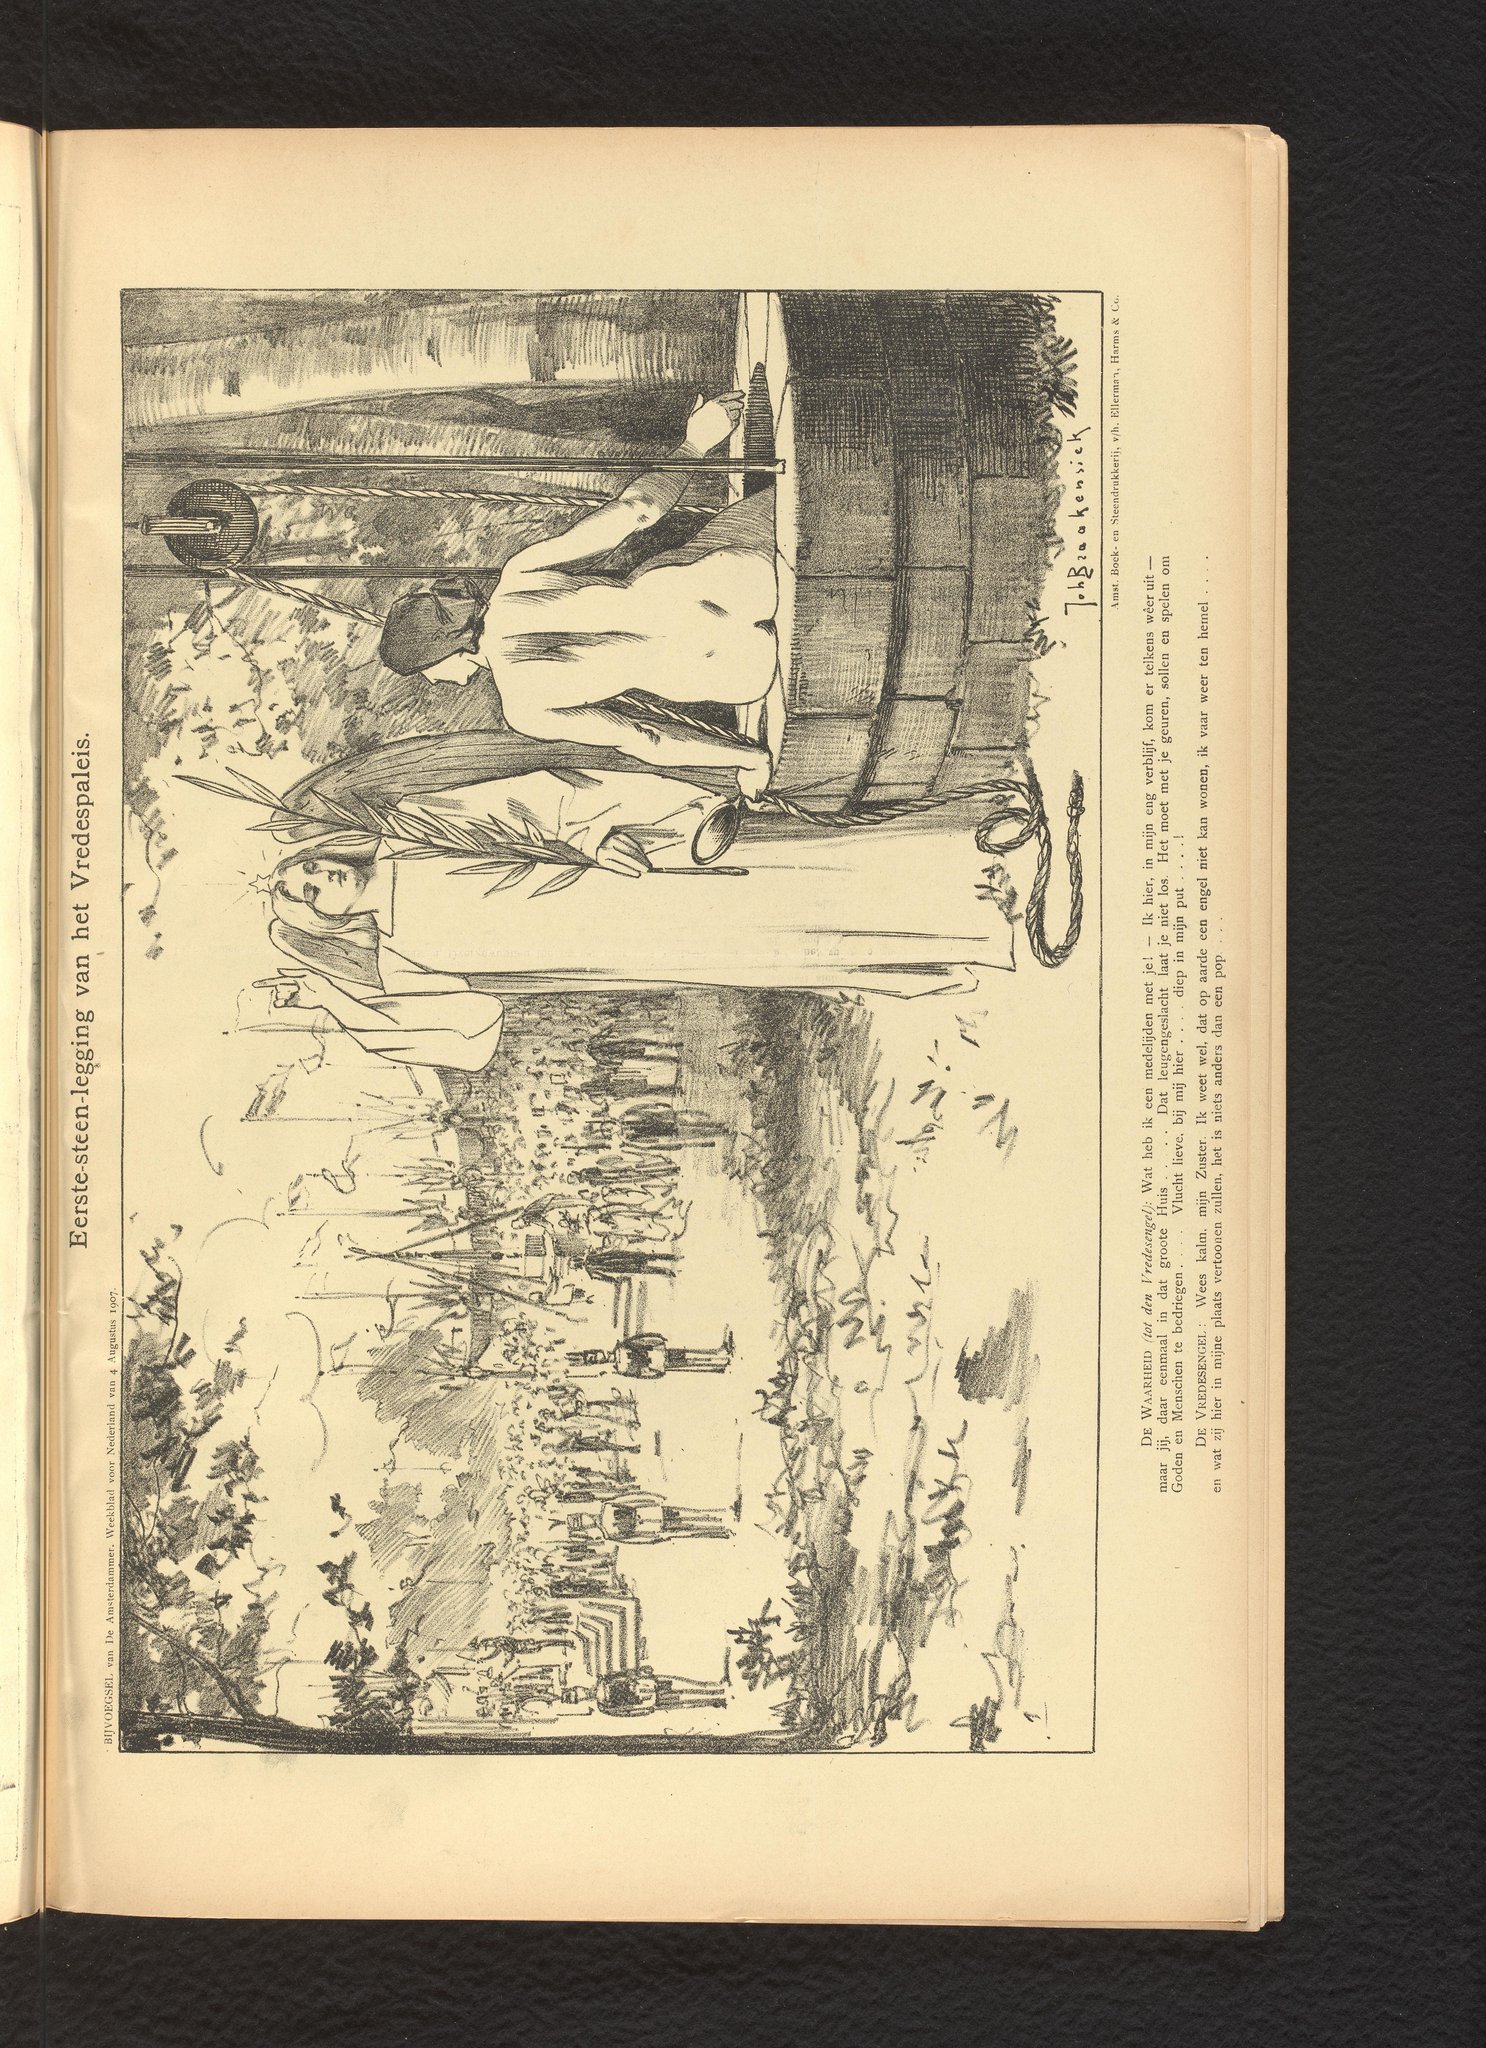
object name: cartoon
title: Eerste-steen-legging van het Vredespaleis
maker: johan braakensiek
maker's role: draughtsman, print maker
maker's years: 1858-1940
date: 1907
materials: paper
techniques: lithograph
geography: netherlands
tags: symbols, allegories of peace, 'pax'; 'pace' (ripa), ceremonial laying of the foundations, laying the first stone, political caricatures and satires, truth; 'verità' (ripa) (+ nude)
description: In Den Haag wordt ceremonieel de eerste steen gelegd voor het Vredespaleis. Op de voorgrond vraagt de Waarheid aan de vredesengel om samen met haar in de put te vluchten.